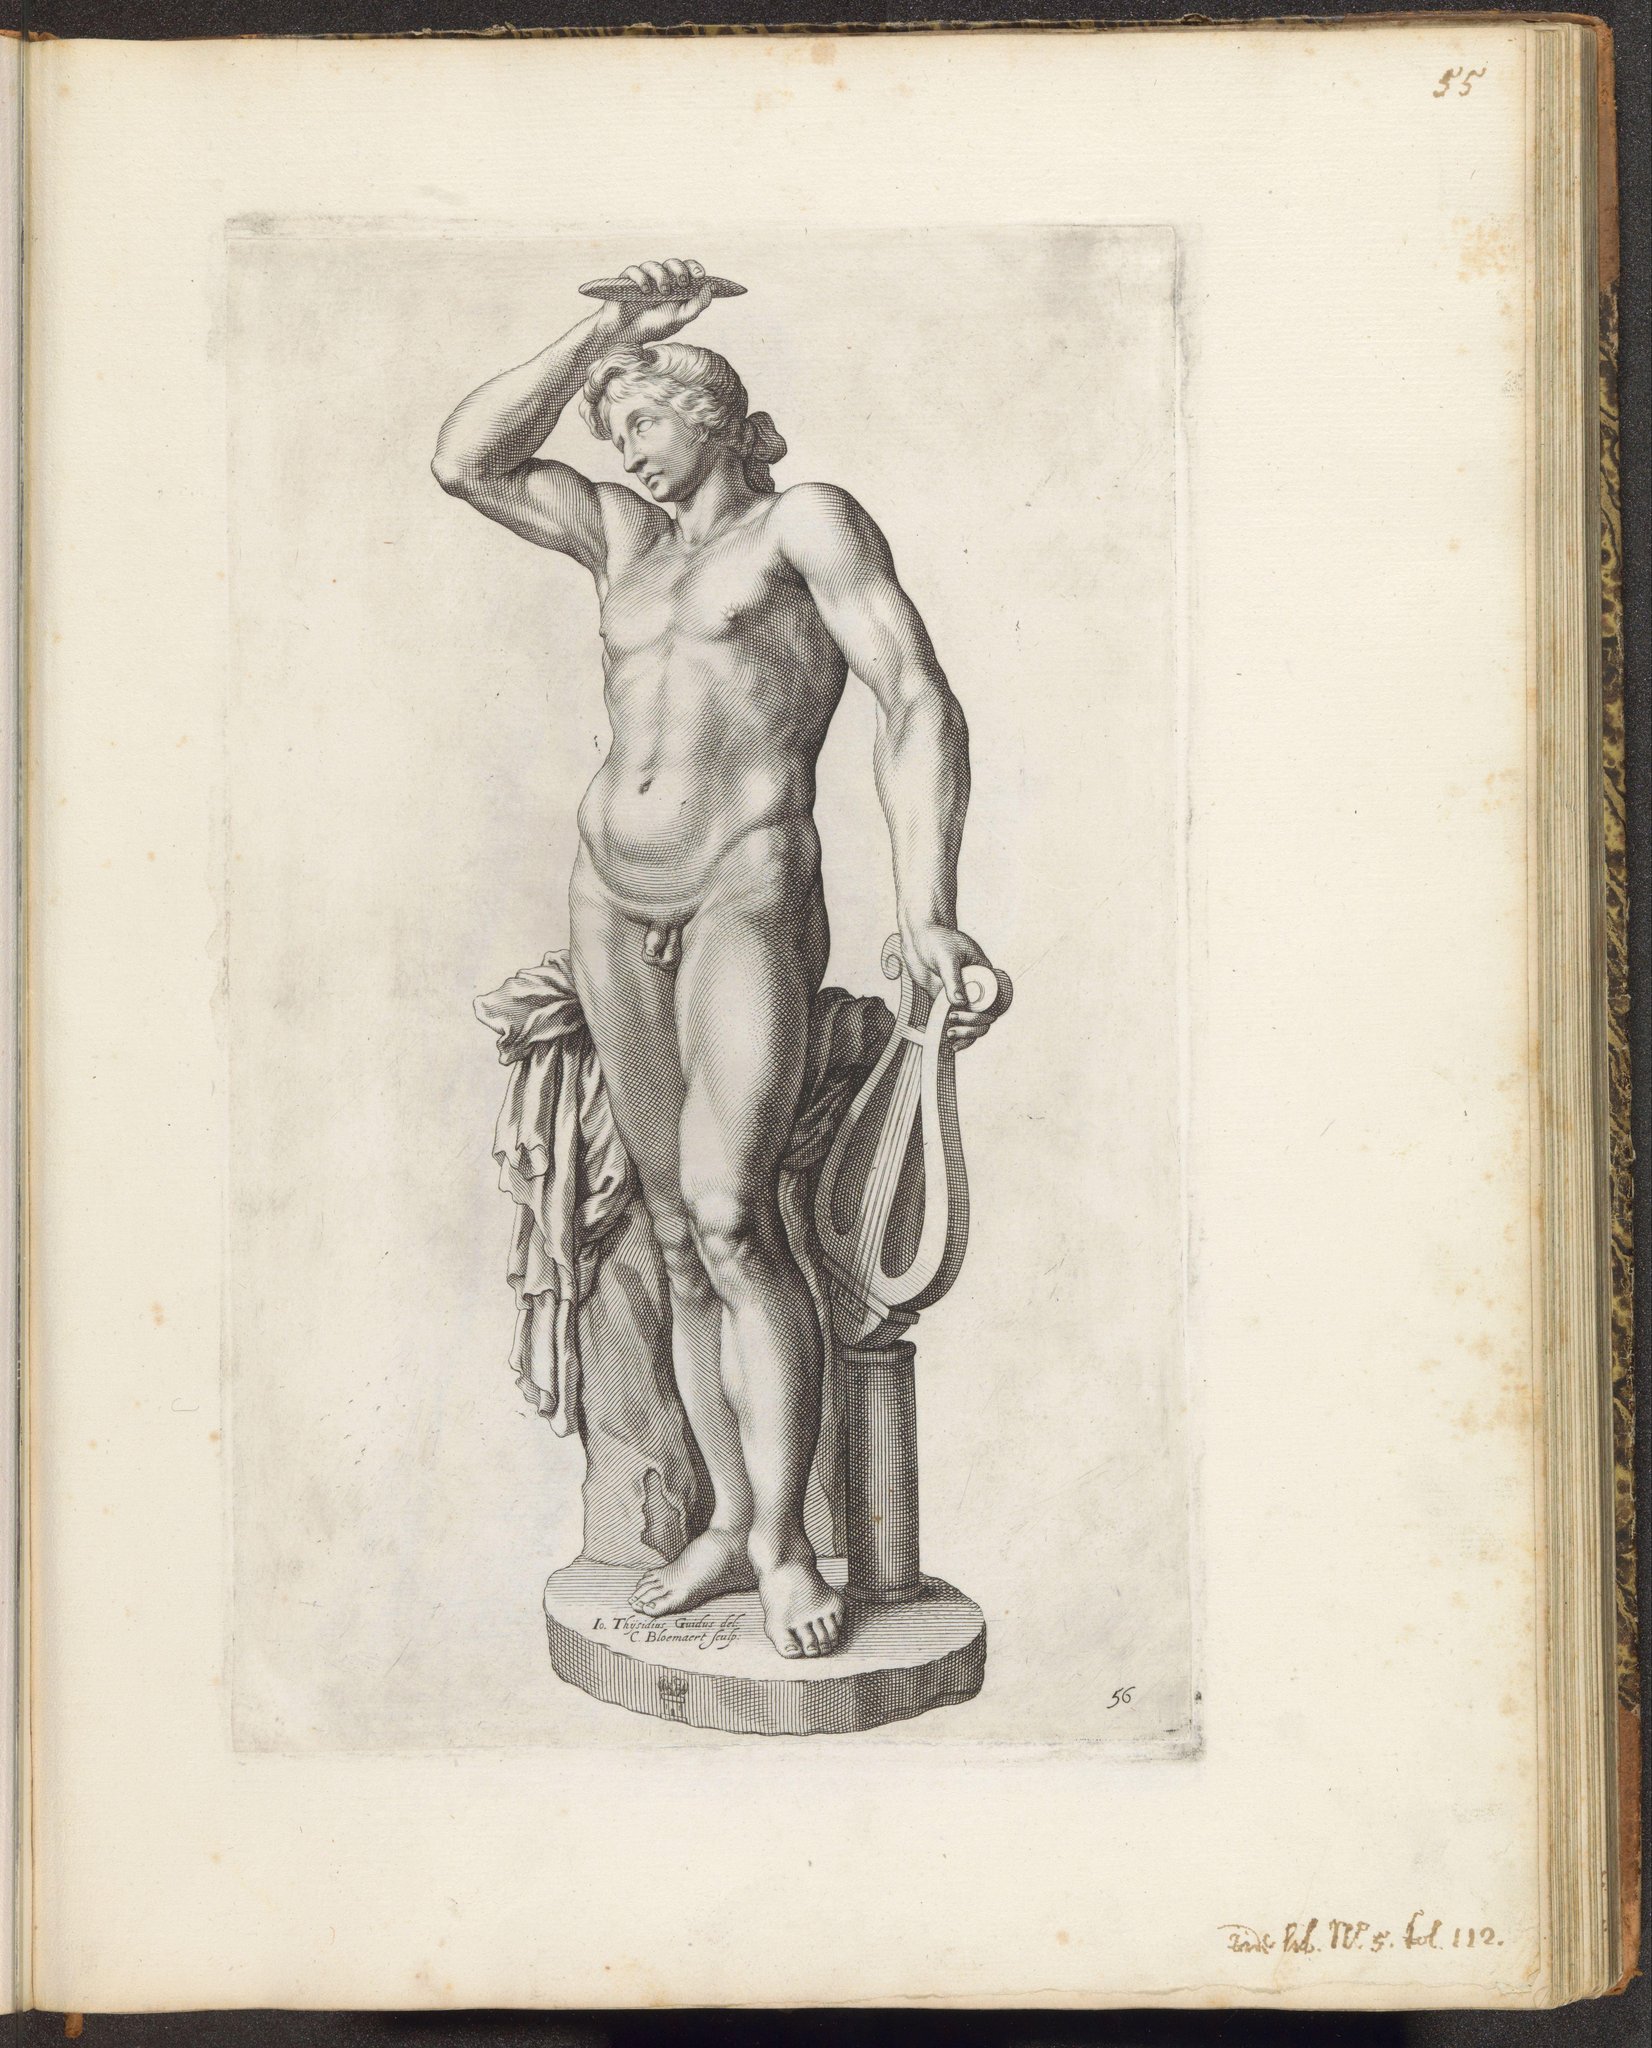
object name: album leaf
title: Galleria Giustiniana del Marchese Vincenzo Giustiniani I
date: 1636-1647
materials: paper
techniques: engraving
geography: rome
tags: (story of) apollo (phoebus), piece of sculpture, reproduction of a piece of sculpture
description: Beeld van de god Apollo met een lier in zijn hand. Zijn haar wordt bij elkaar gehouden met een haarband. Op de basis het wapenschild van Vincenzo Giustiniani. Prent maakt deel uit van een album met een serie prenten naar de sculpturen in de verzameling in de Galleria Giustiniani te Rome.